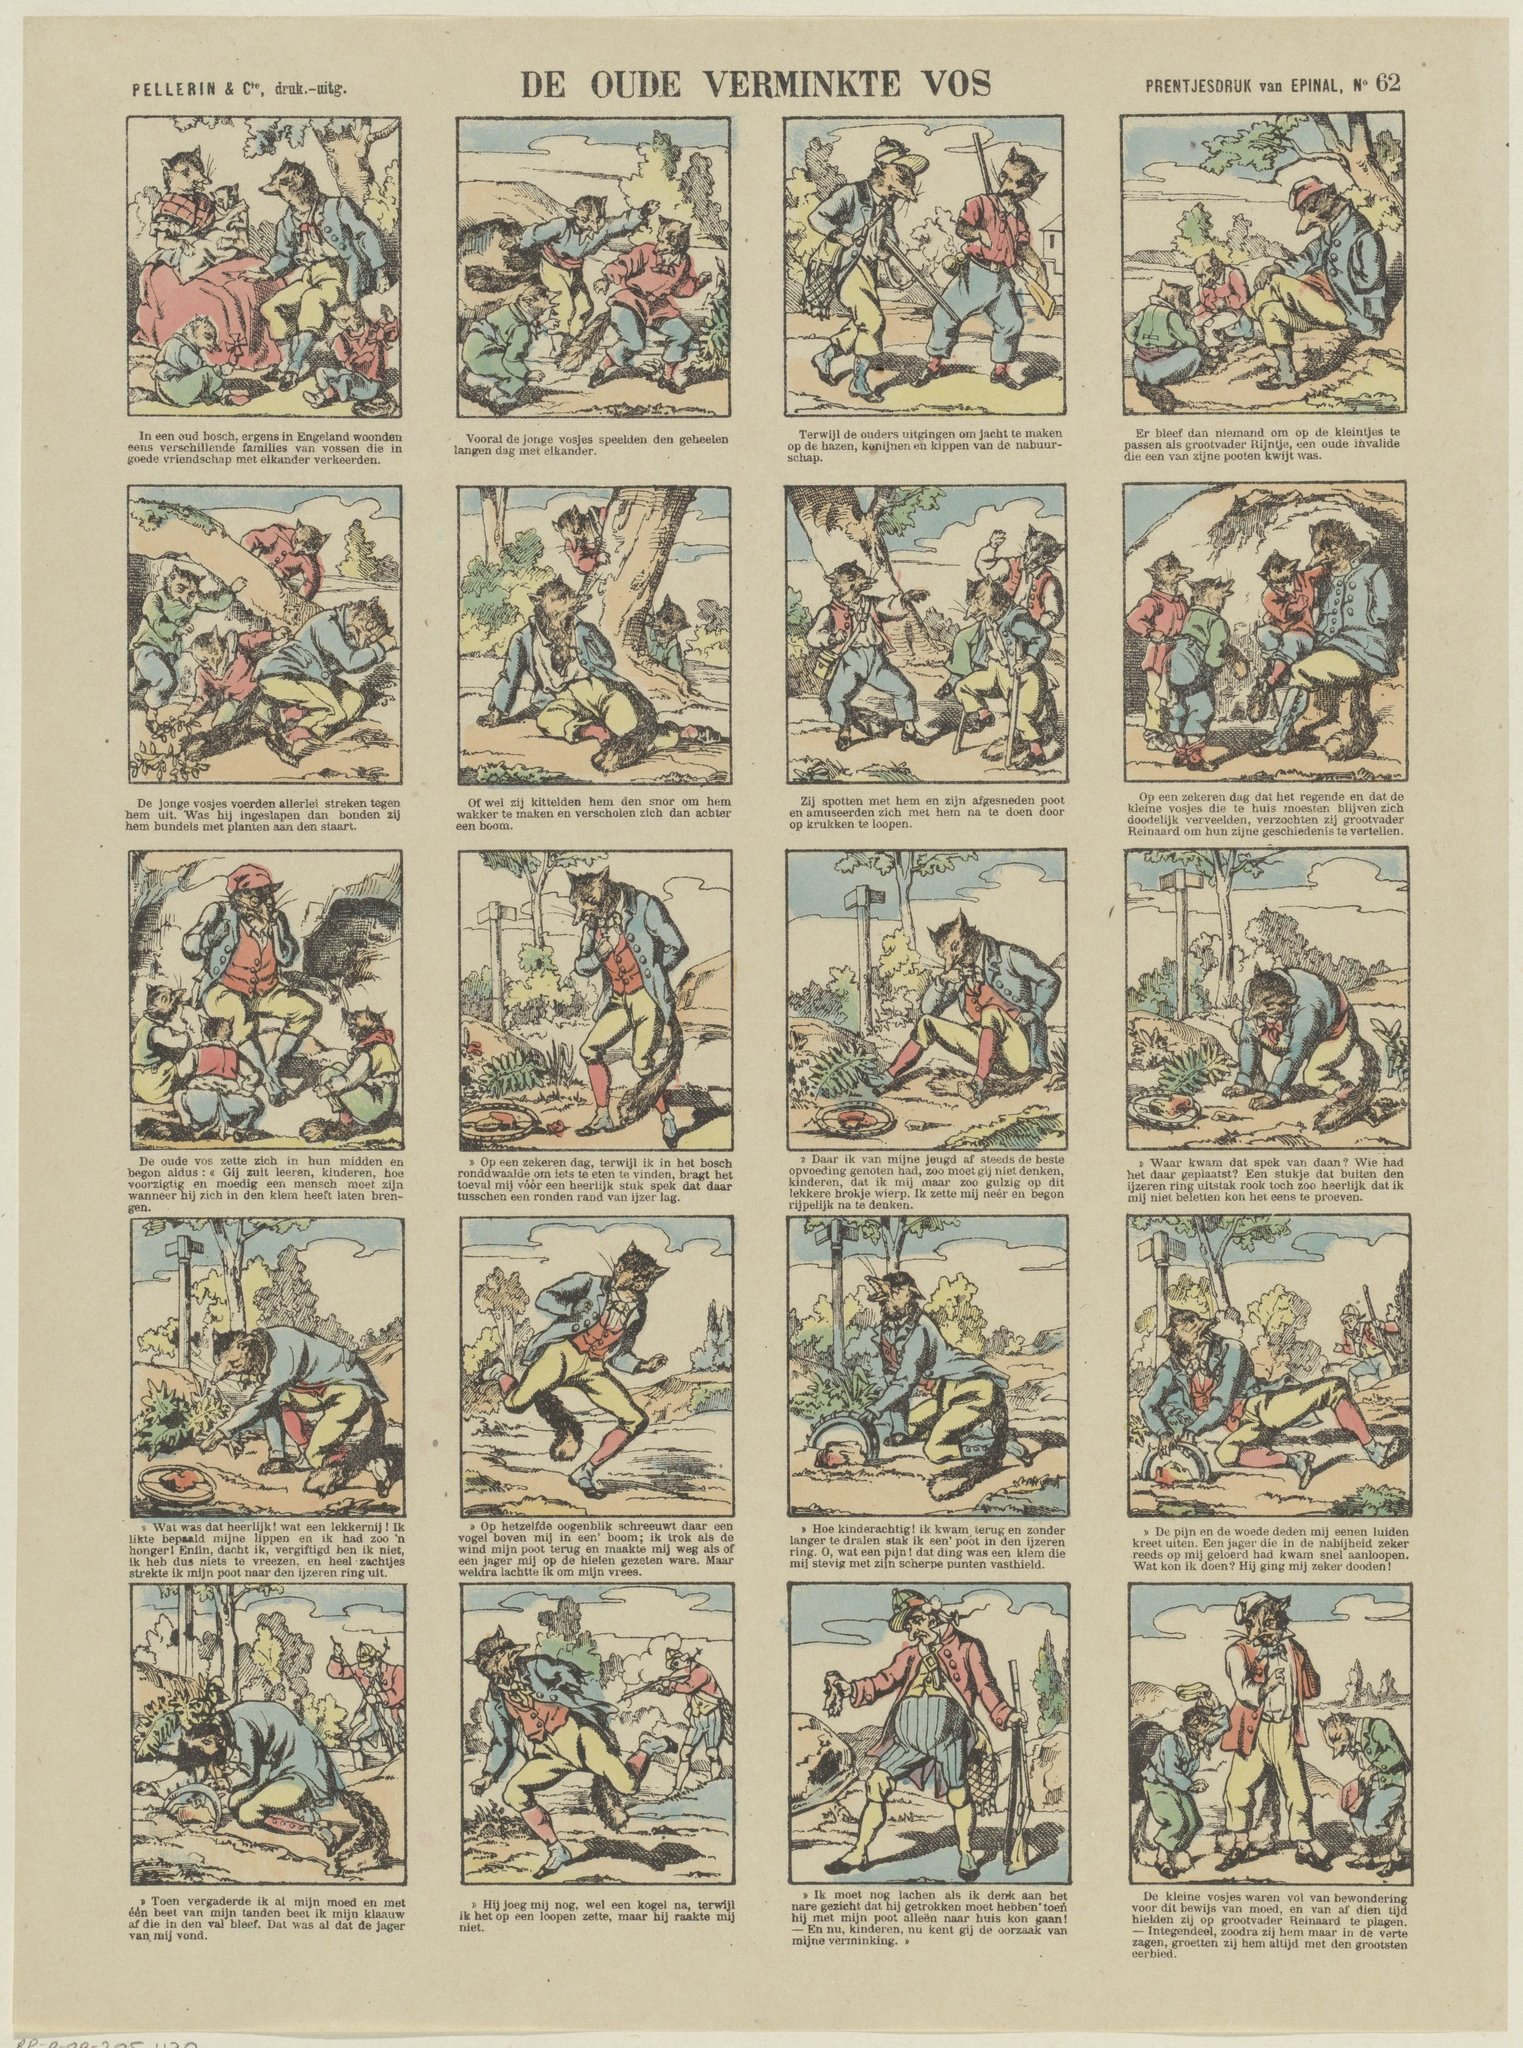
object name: popular print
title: Prentjesdruk van Épinal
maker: Anonymous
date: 1902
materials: paper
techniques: colour, letterpress printing, lithograph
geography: epinal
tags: story teller; listening to story teller, animals acting as human beings, tales and fairy tales, beasts of prey, predatory animals: fox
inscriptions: collector's mark: Lugt 2760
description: Blad met 20 voorstellingen over een oude verminke vos, die een verhaal vertelt aan zijn kleinkinderen. Onder elke afbeelding een onderschrift. Genummerd rechtsboven: No 62.